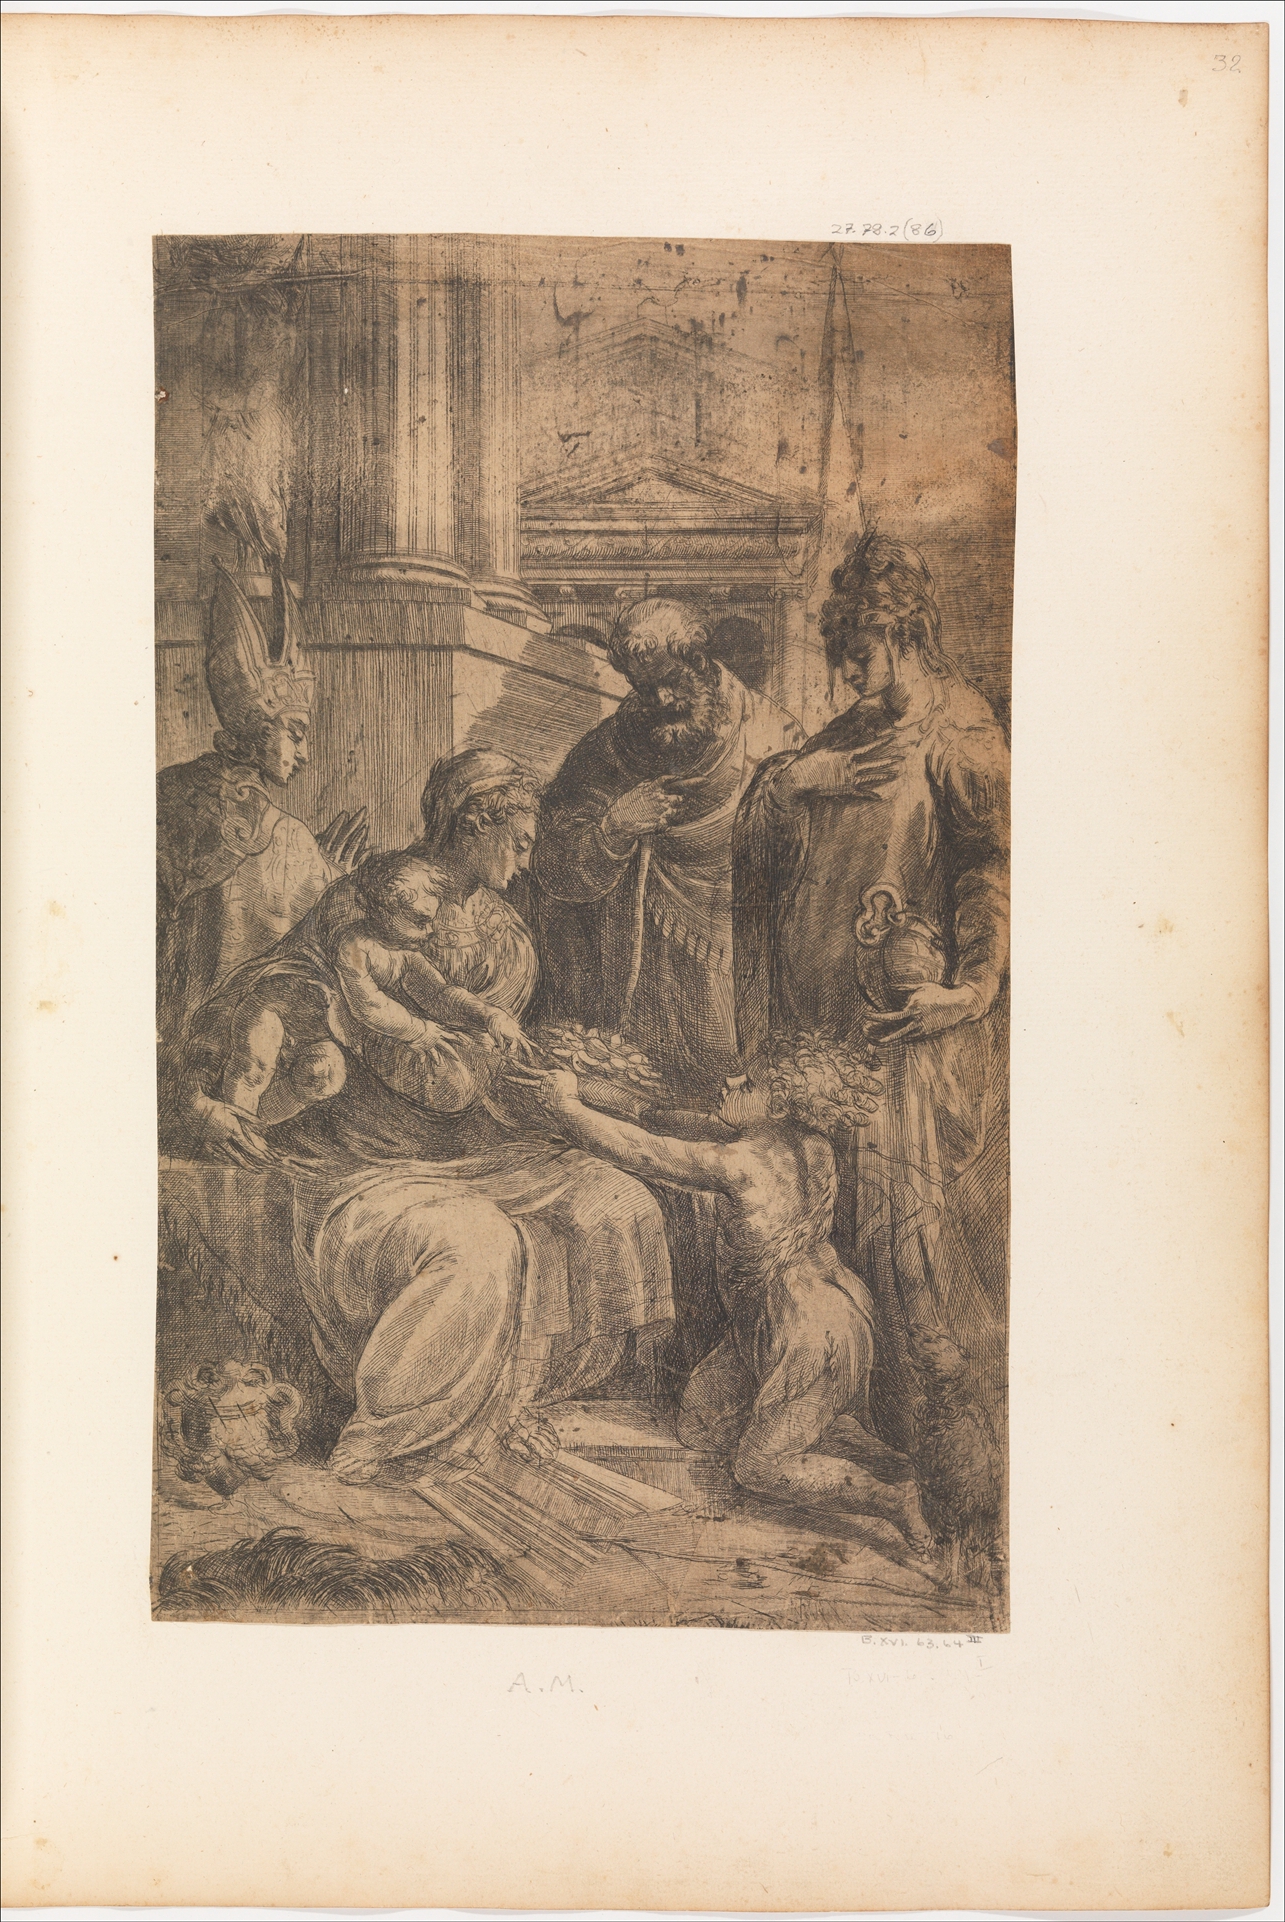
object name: print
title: Holy Family with Saints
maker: andrea schiavone (andrea meldola)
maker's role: artist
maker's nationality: italian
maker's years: 1510-1563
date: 1550-1554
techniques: etching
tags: men,holy family,saints